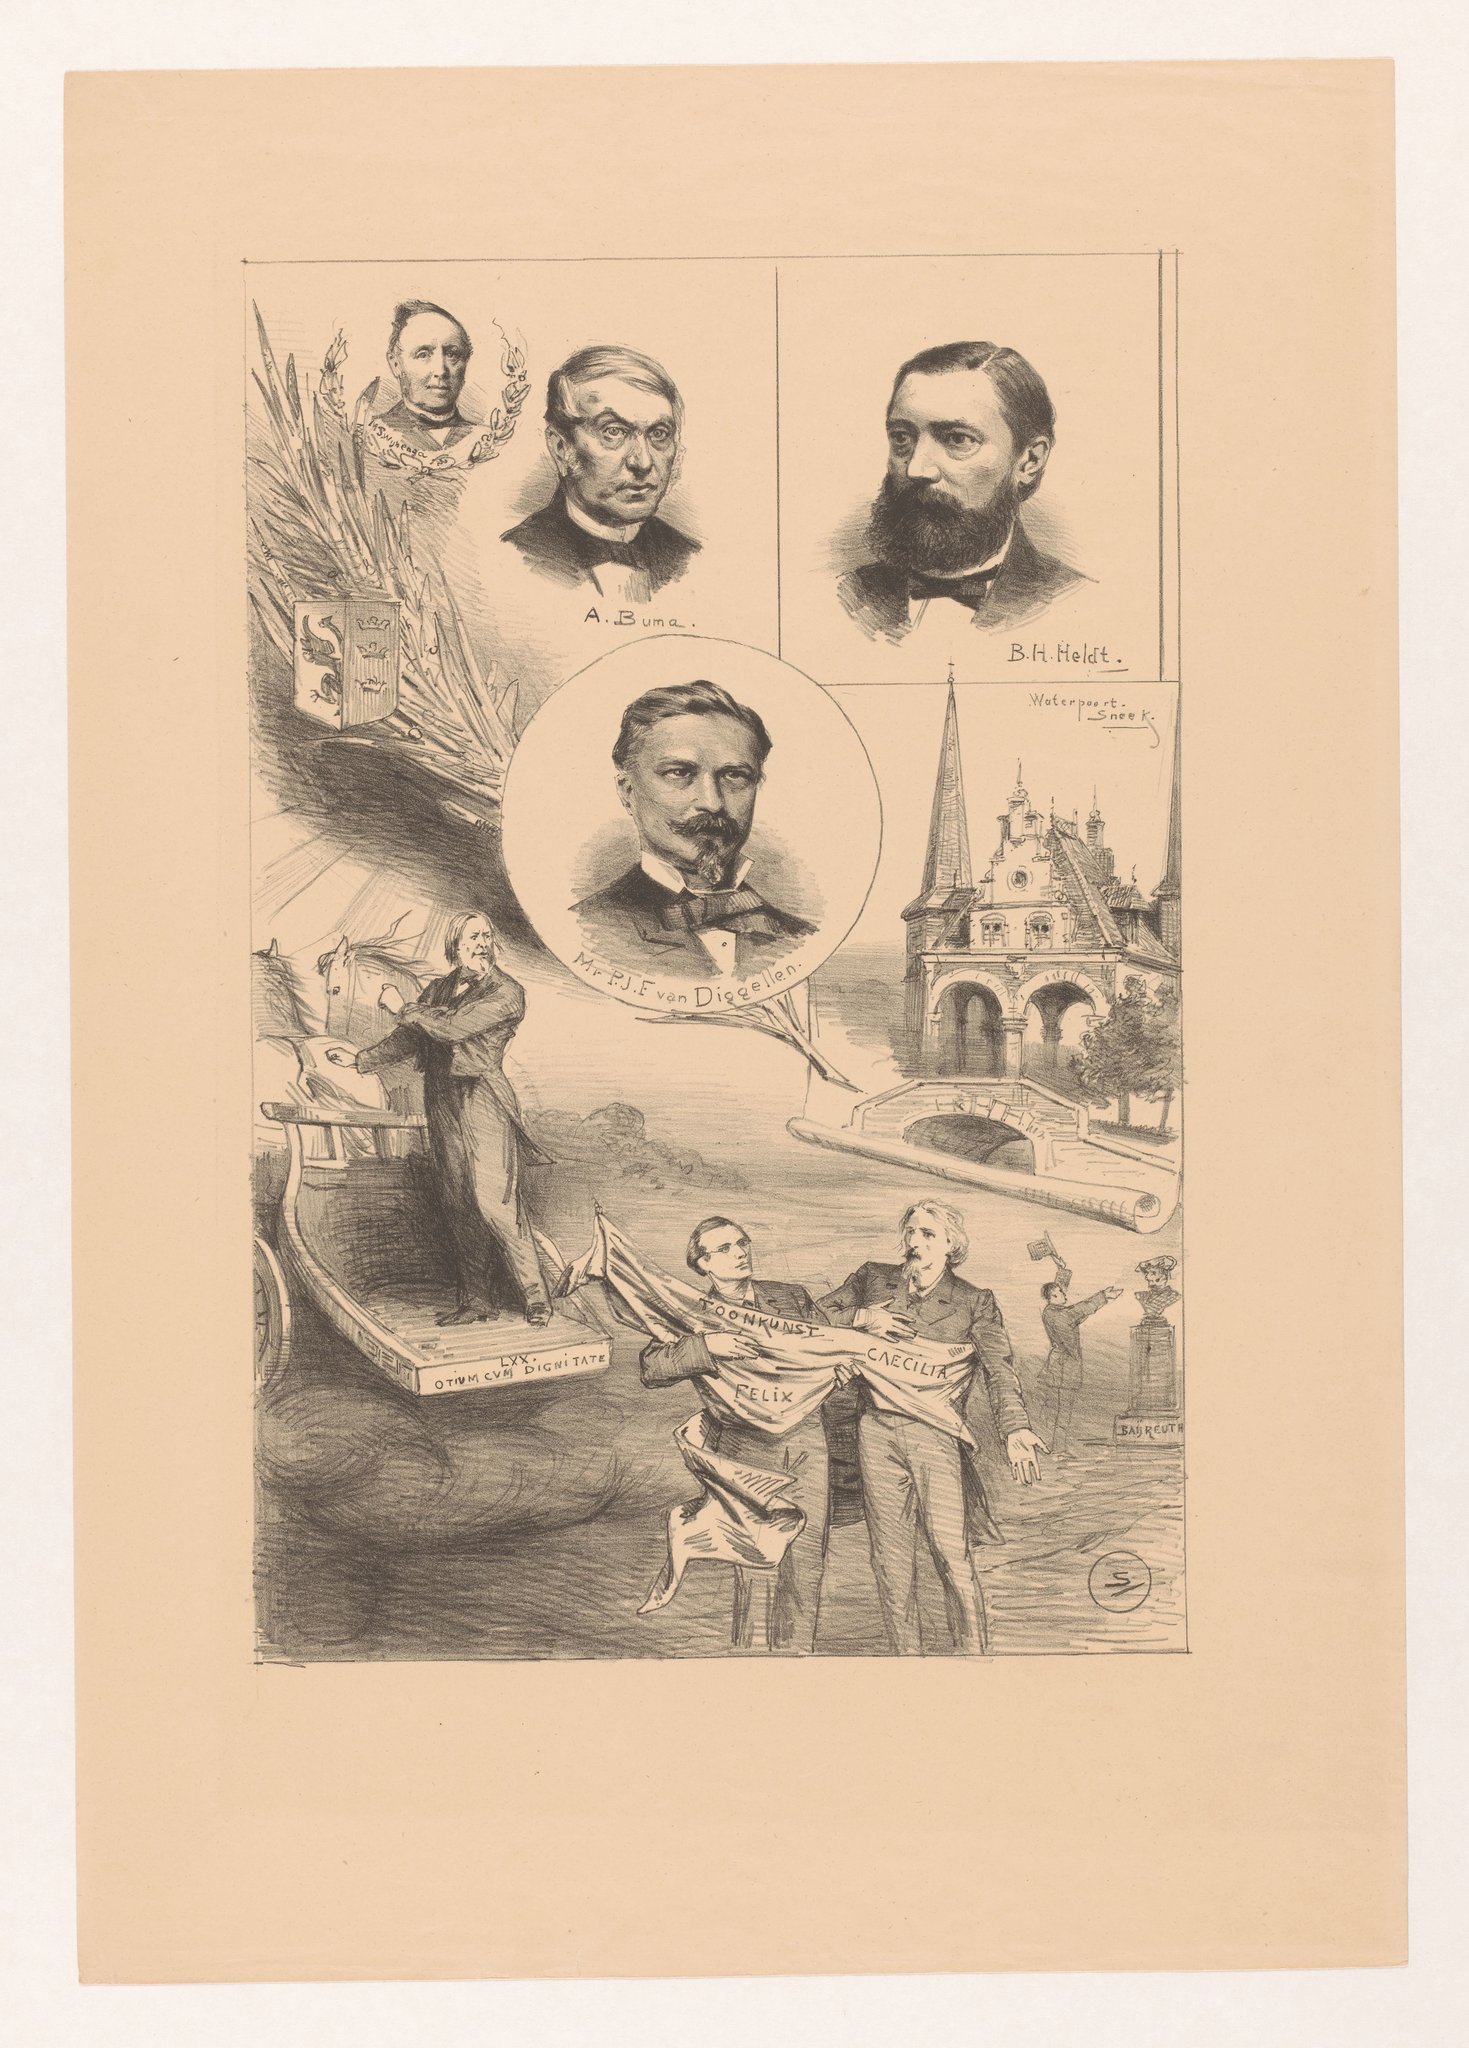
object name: cartoon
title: Vier portretten, de Waterpoort te Sneek en spotprent op pensionering Johannes Verhulst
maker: willem steelink (ii)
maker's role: draughtsman, print maker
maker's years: 1856-1928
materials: paper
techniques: lithograph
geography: netherlands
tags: harlingen, politician, pieter johannes gesinus van diggelen, amsterdam, arnhem, furniture worker, the hague, johannes verhulst, watergate, historical persons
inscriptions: collector's mark: Lugt 2228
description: Portretten van Schelte Wybenga, Age Buma, Bernardus Hermanus Heldt en Pieter Johannes Gesinus van Diggelen. Rechts de Waterpoort te Sneek. Aan de onderzijde een spotprent met links componist en dirigent Johannes Verhulst op een span met de woorden LXX Otium cum dignitate. Op de voorgrond staan twee mannen met de namen van de orkesten Toonkunst, Caecilia en Felix (Meritis).